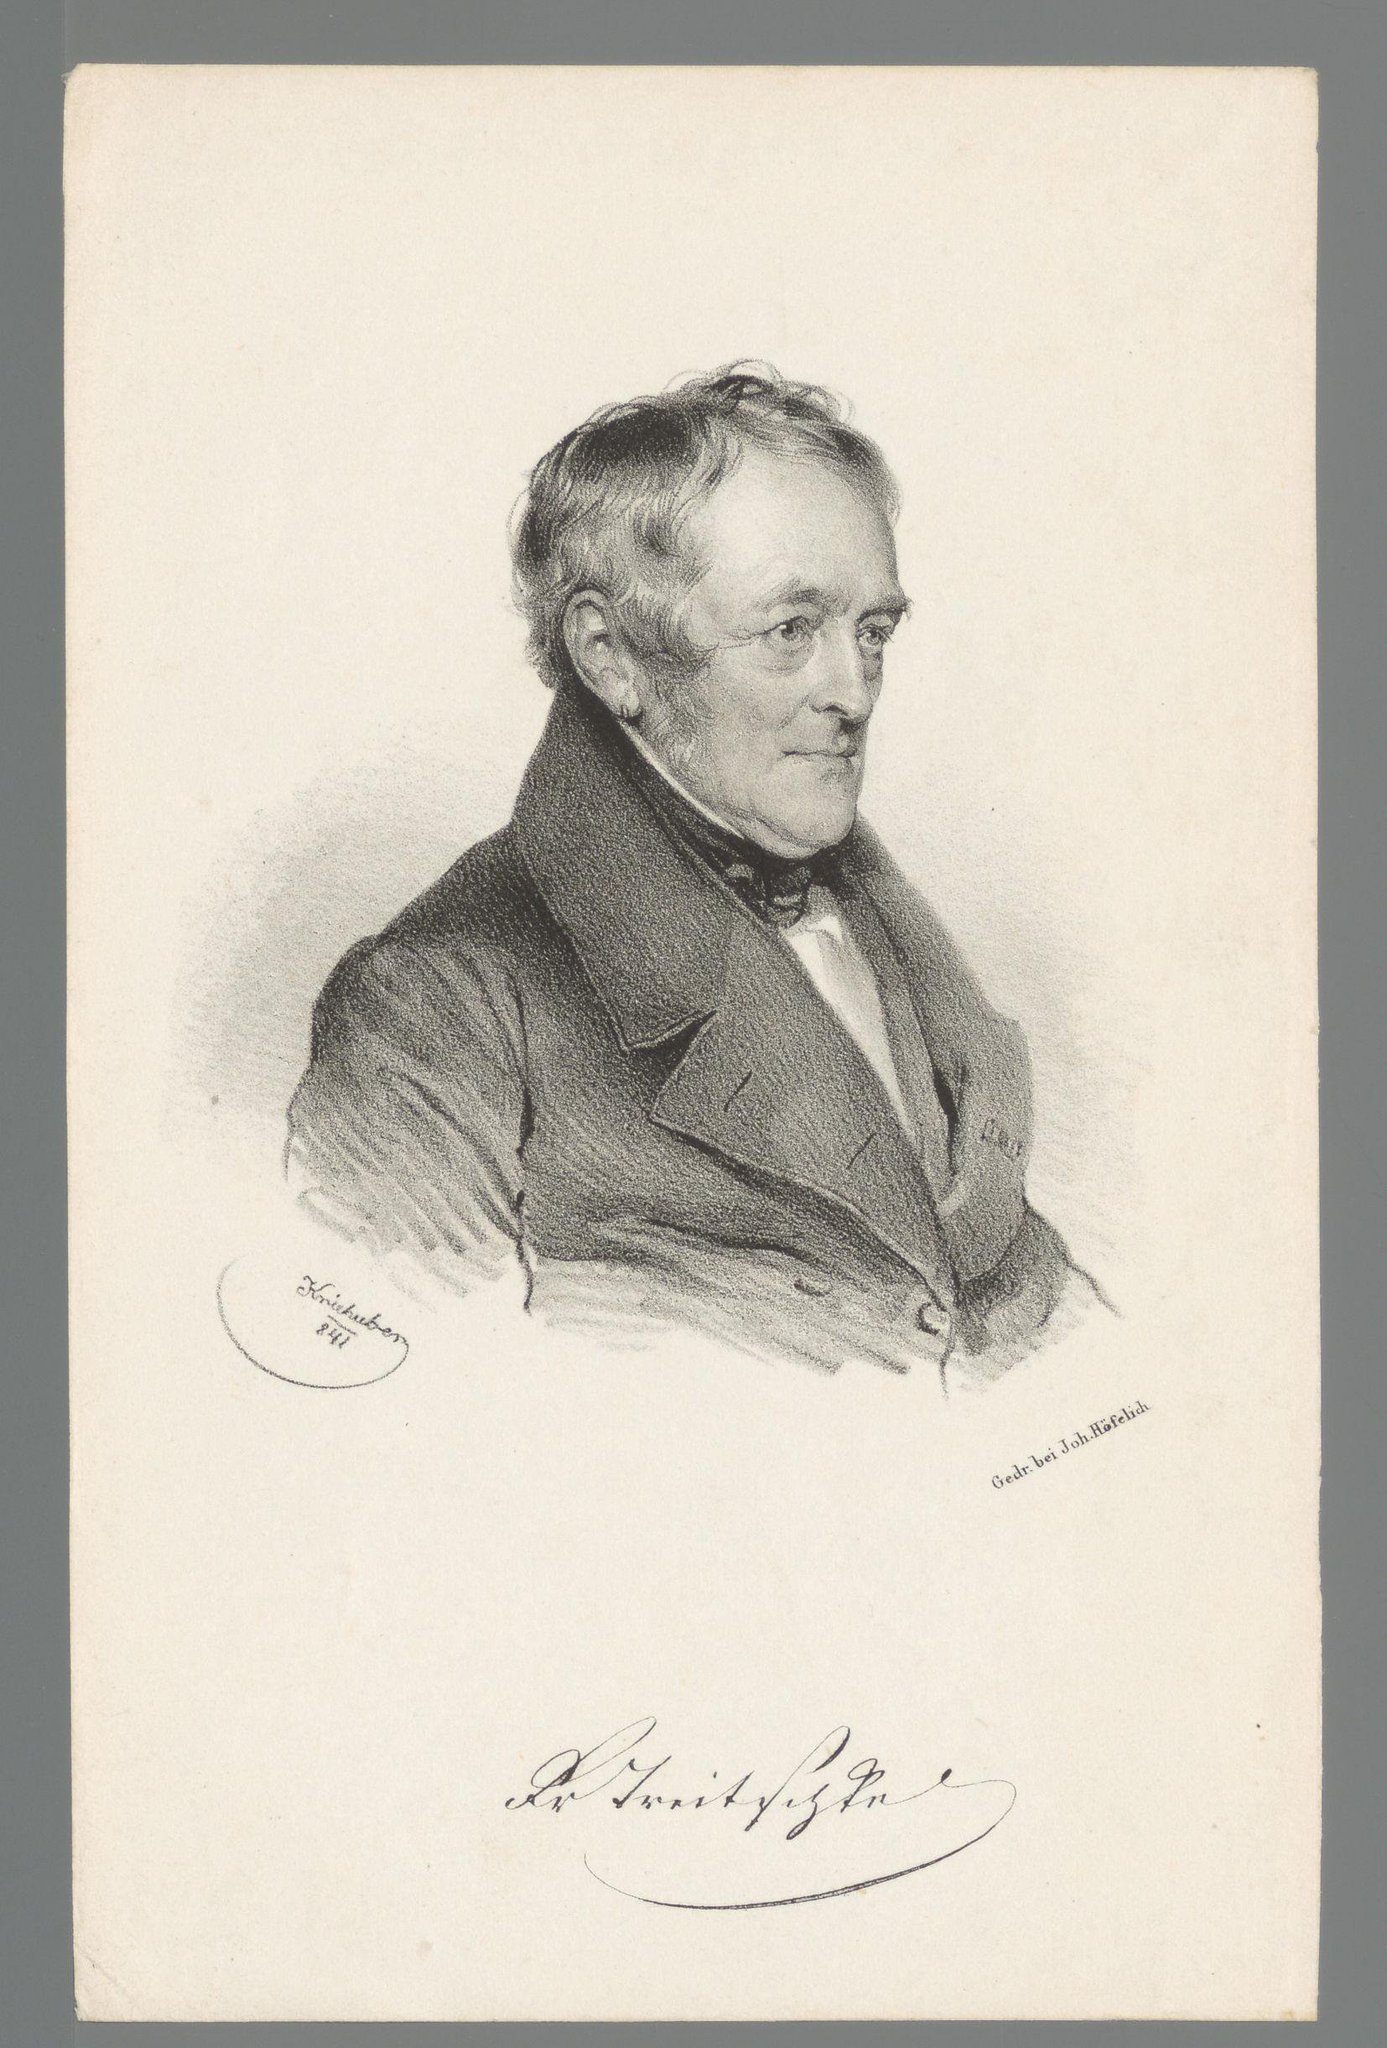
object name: print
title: Portret van Georg Friedrich Treitschke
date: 1841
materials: paper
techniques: lithograph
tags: vienna, theatre, theatrical performance, historical persons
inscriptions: collector's mark: Lugt 2228